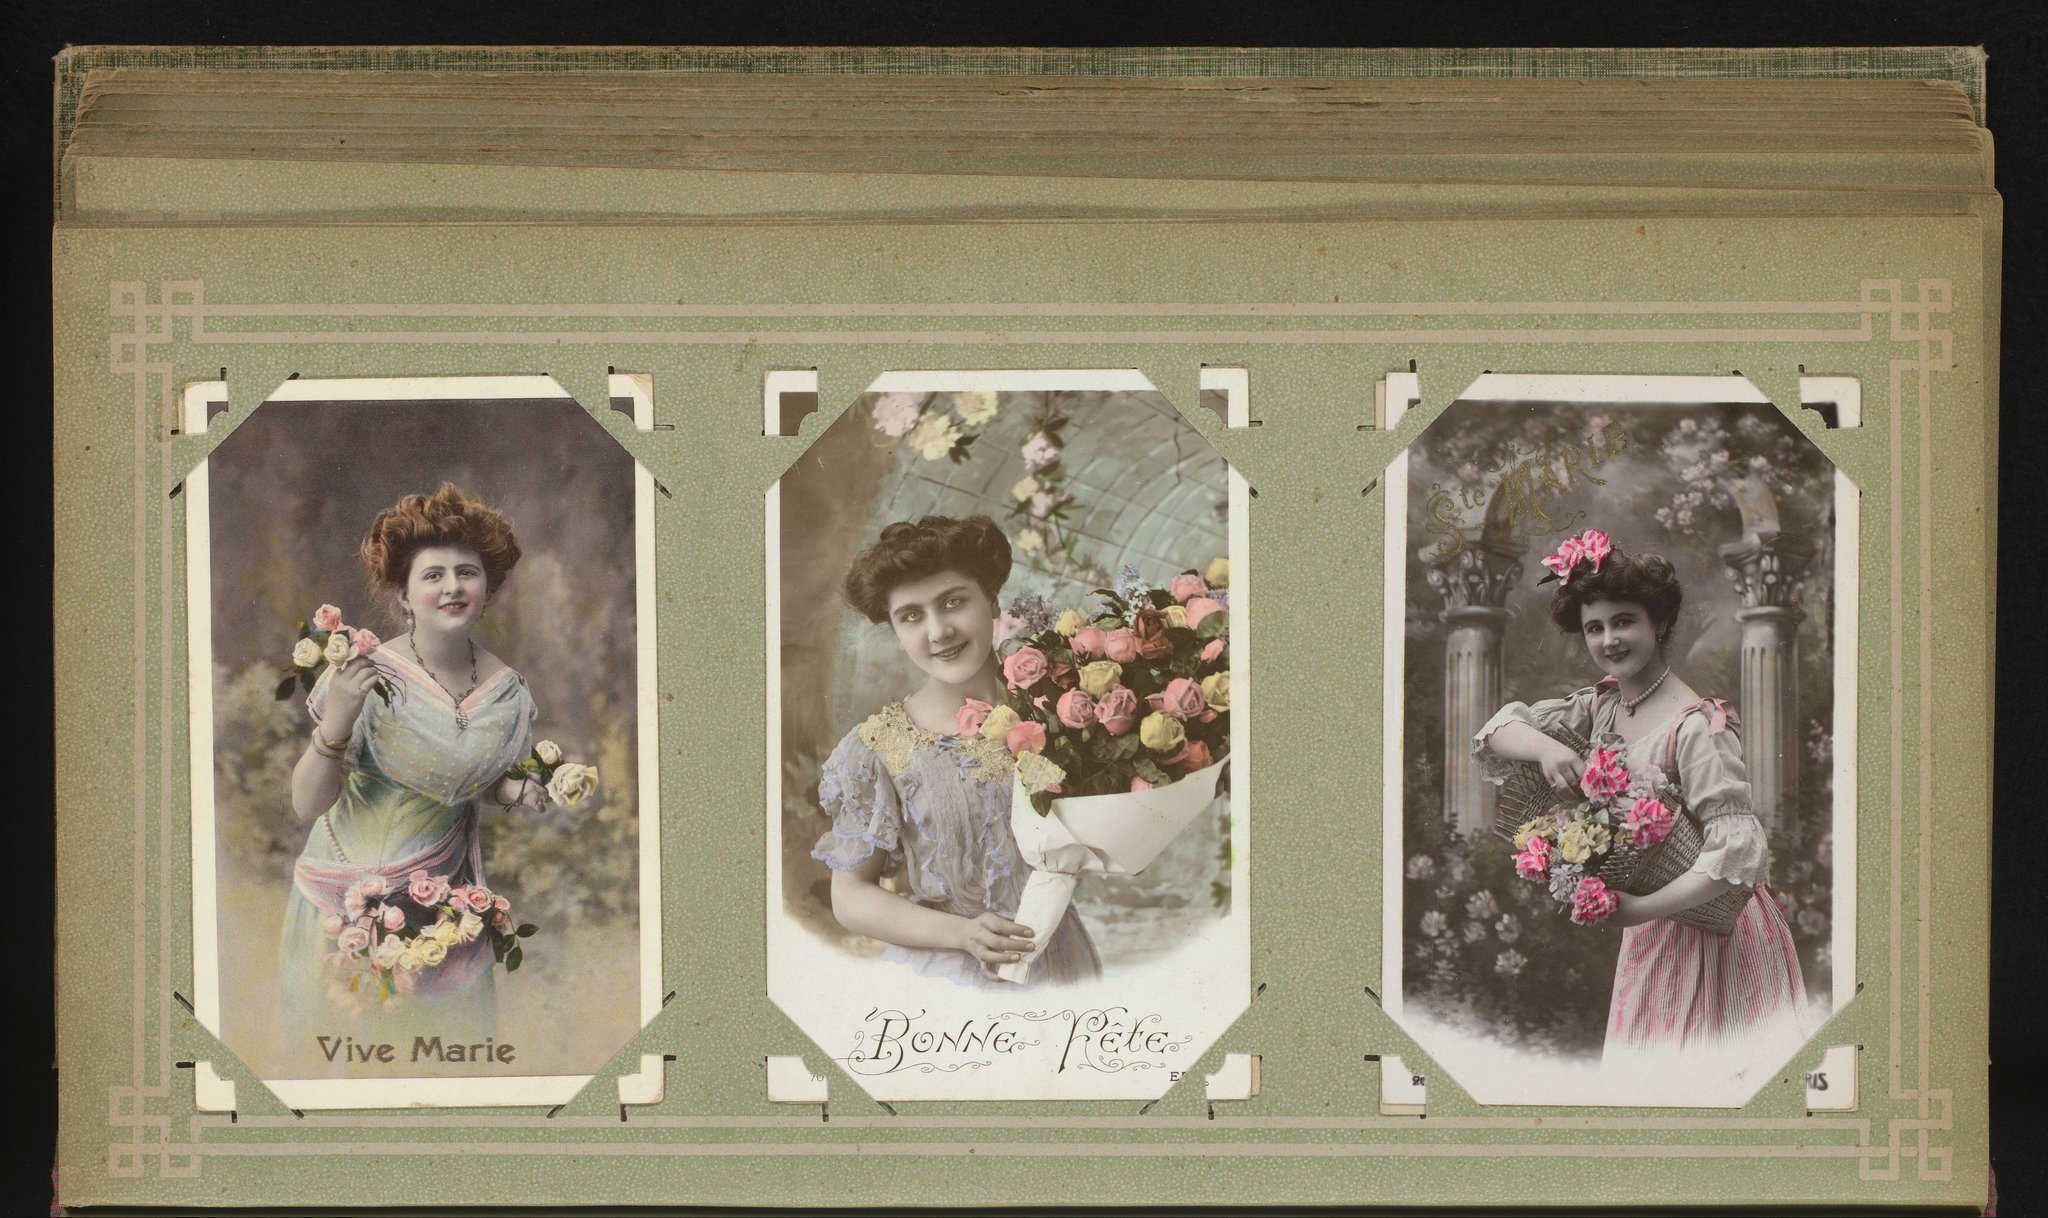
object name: ansichtkaart, prentbriefkaart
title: Drie portretten van vrouwen met bloemen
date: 1900-1930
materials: cardboard, photographic support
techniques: gelatin silver print, hand coloring, relief print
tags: flowers, historical persons - bb - woman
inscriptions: monogram: ‘EPR’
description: Deze foto's en prent maken deel uit van een album.